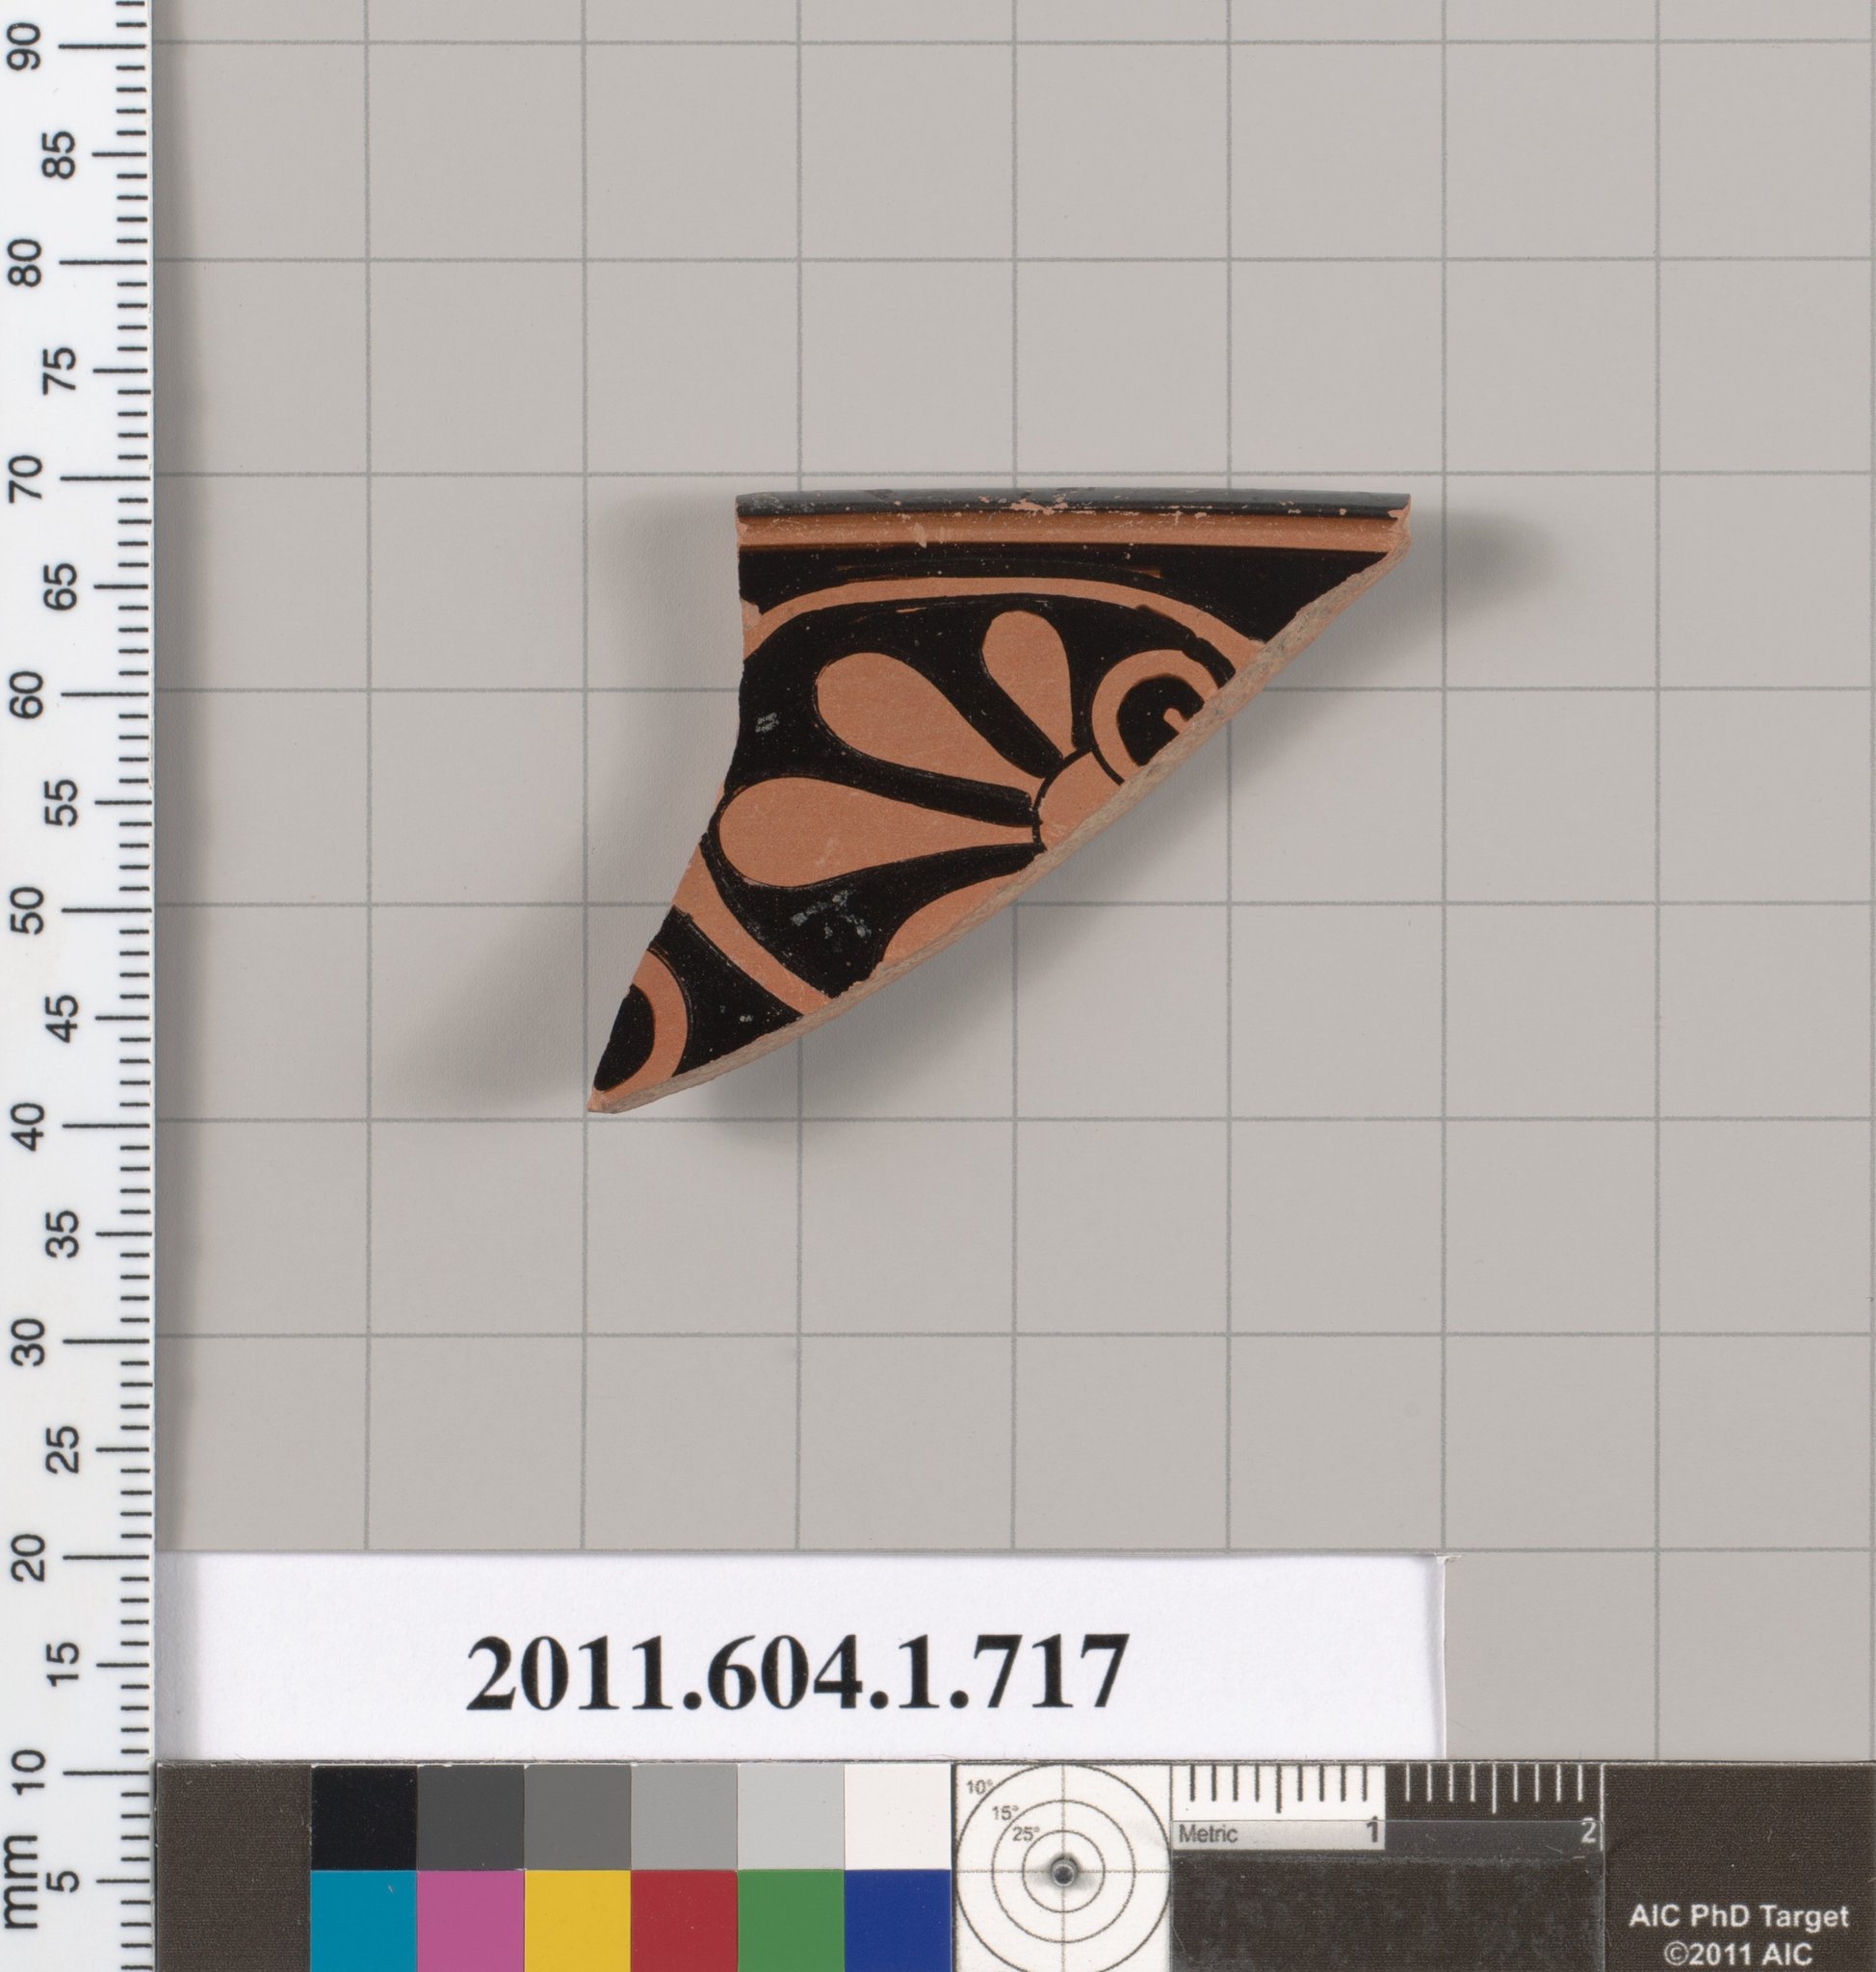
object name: kylix fragment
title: Terracotta rim fragment of a kylix (drinking cup)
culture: greek, attic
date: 500-476 BCE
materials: terracotta